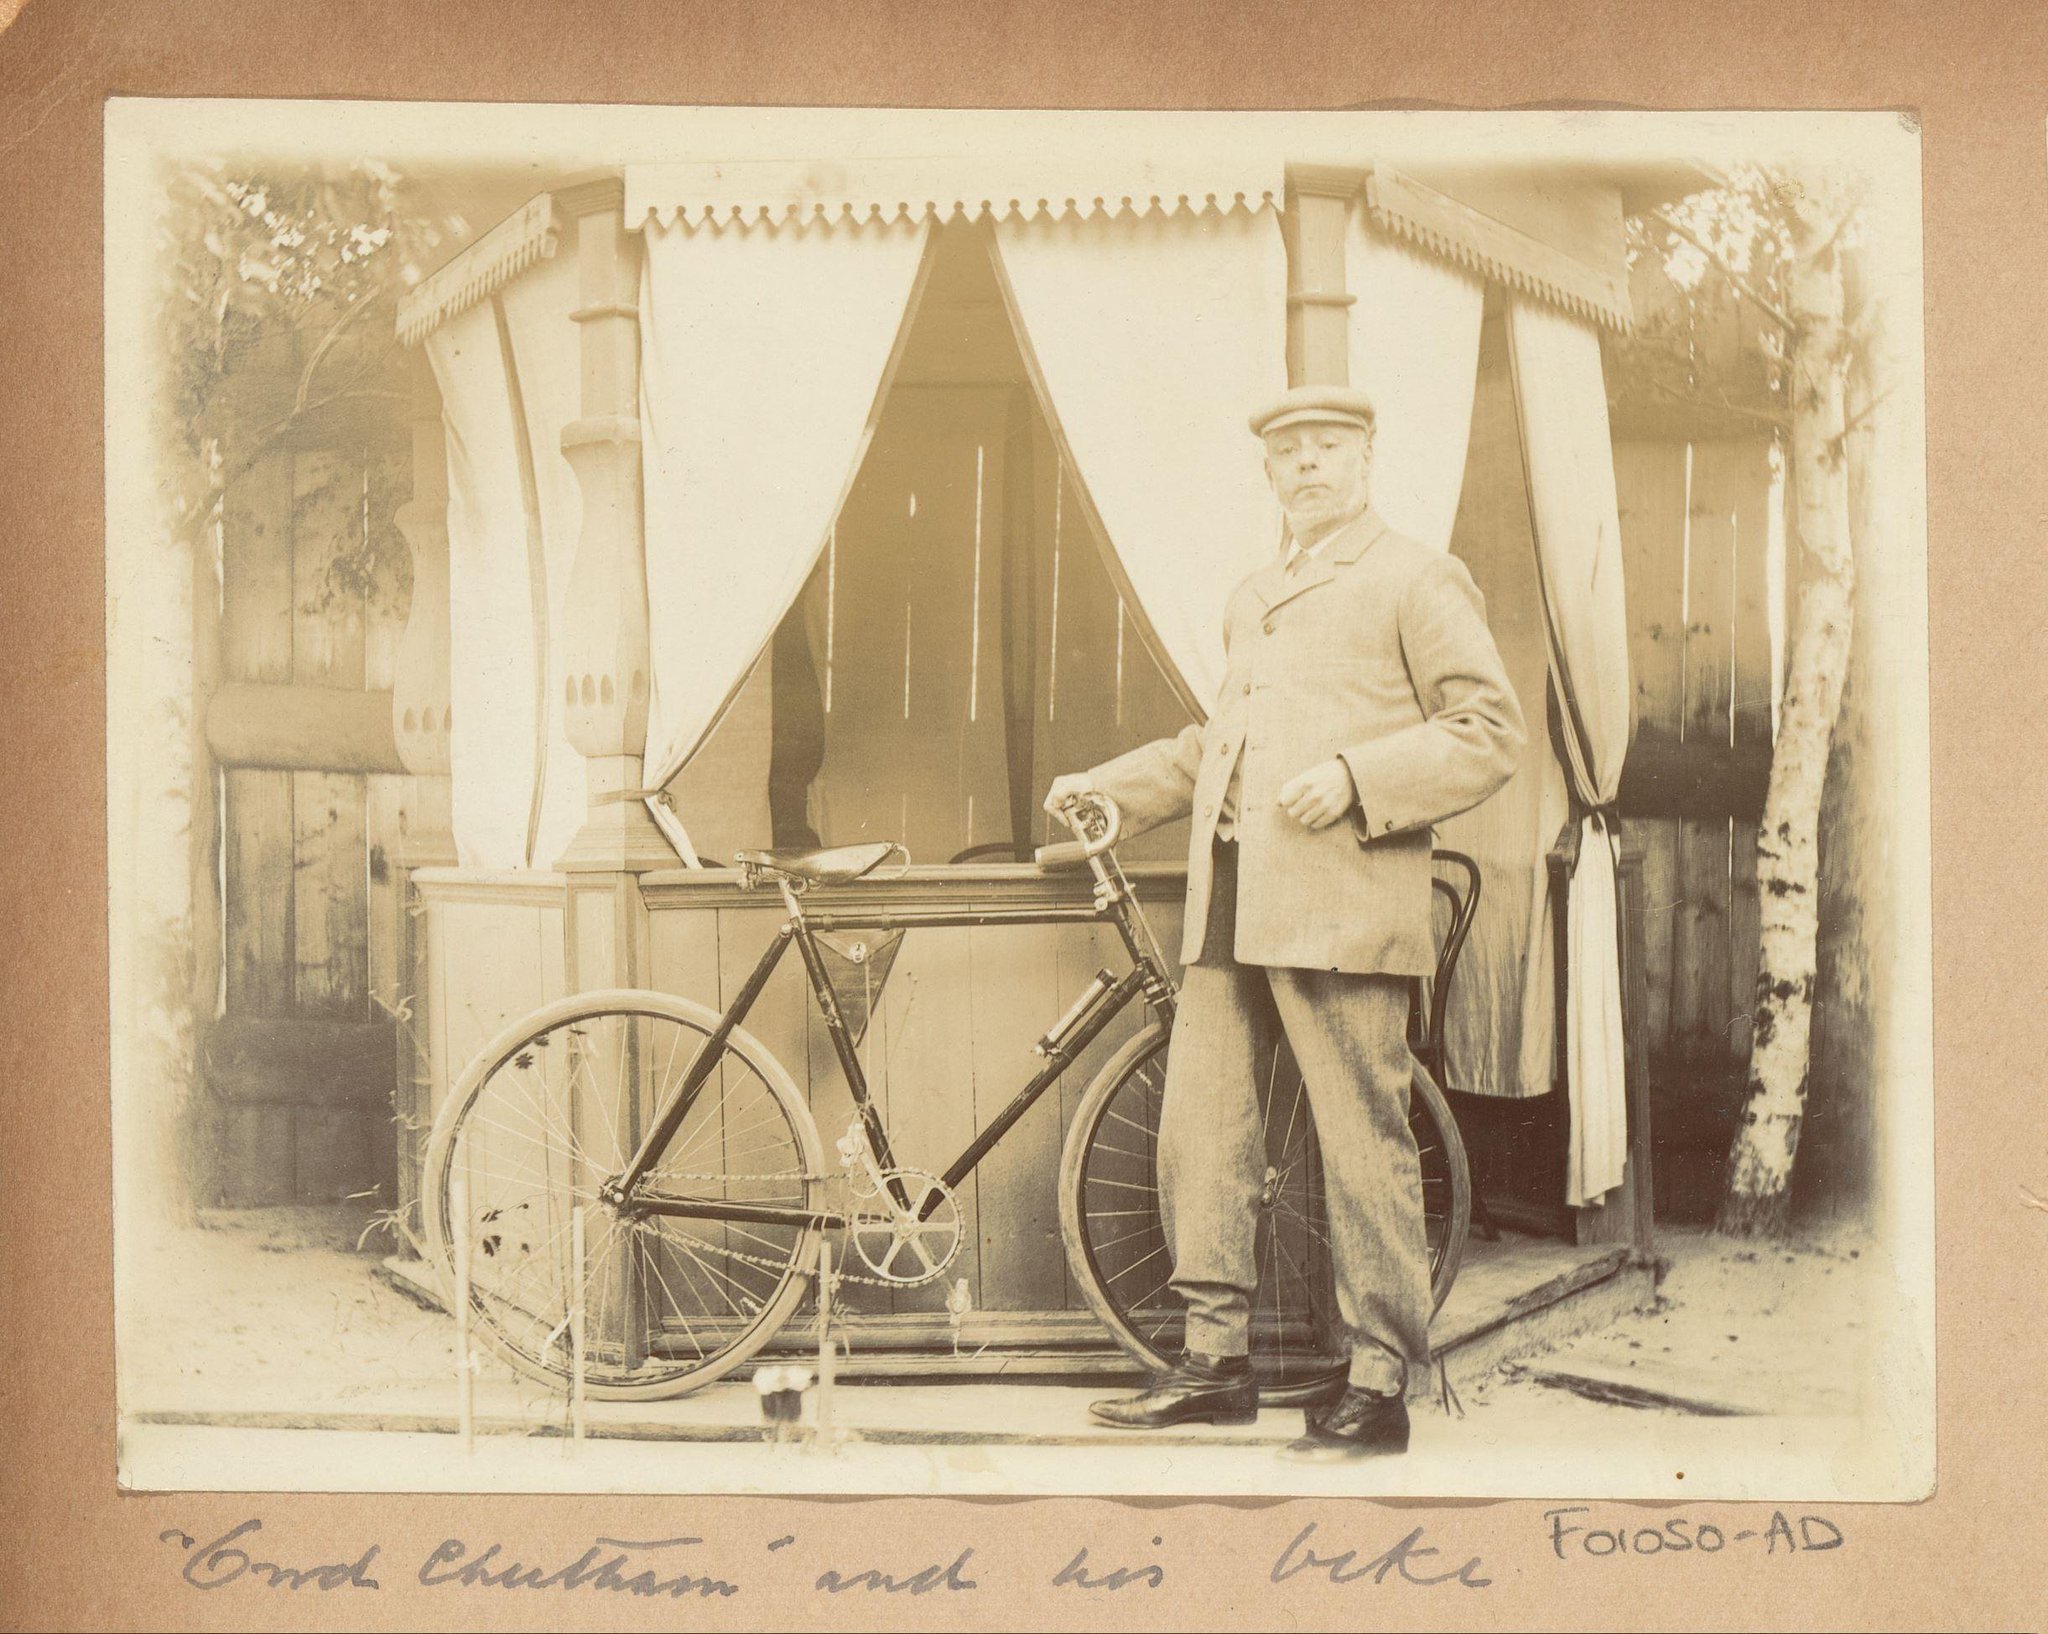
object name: photograph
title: Joseph Cheetham poserend naast zijn fiets in Rusland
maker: joseph cheetham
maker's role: engineer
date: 1903-1904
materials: photographic support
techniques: gelatin silver print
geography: russia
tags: adult man, bicycle, russia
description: Onderdeel van Fotoalbum van de Engelse familie Cheetham met opnames van hun verblijf in Rusland.